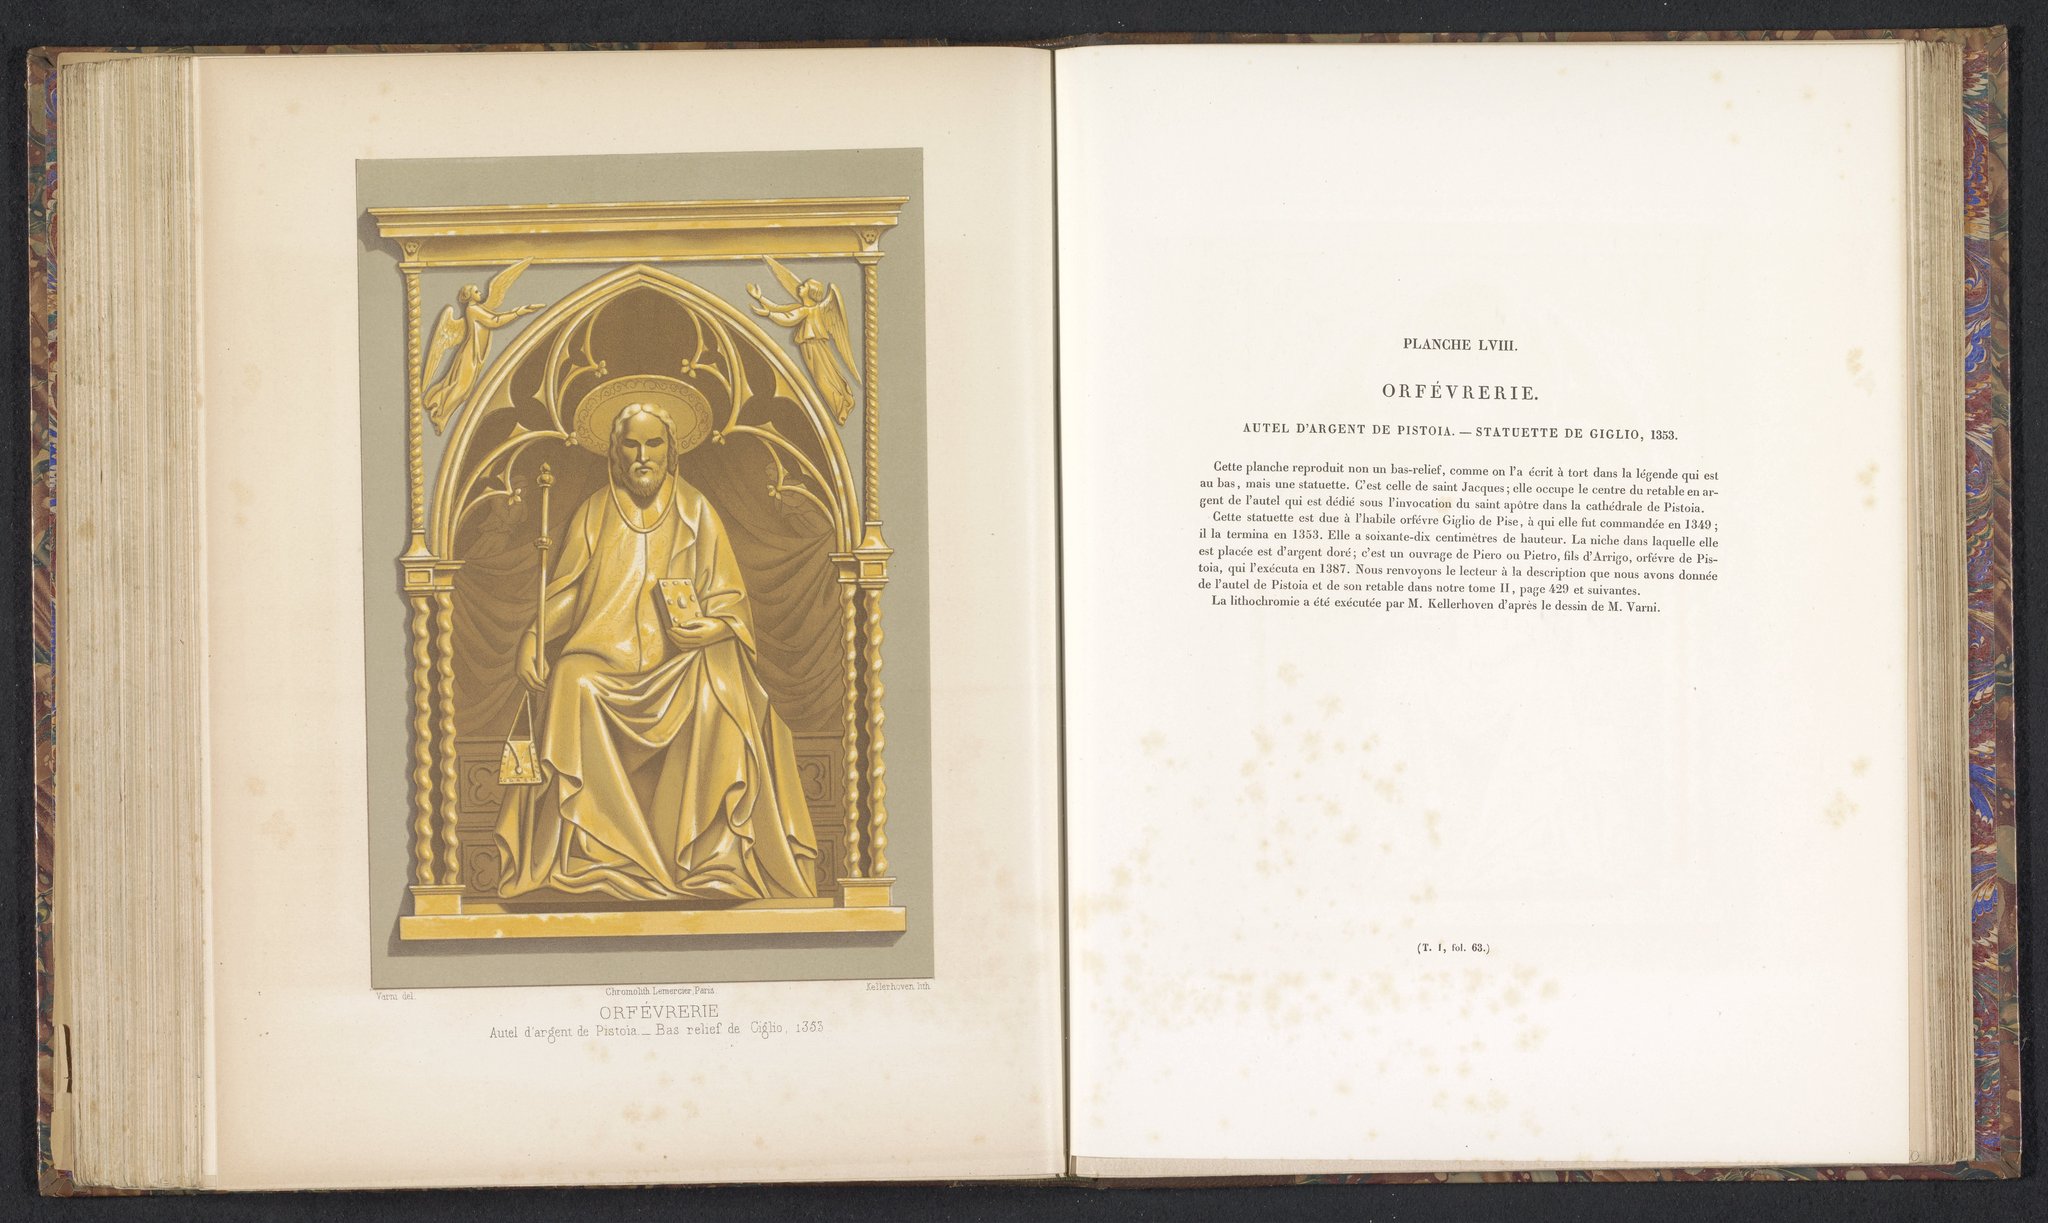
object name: print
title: Orfévrerie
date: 1859-1864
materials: paper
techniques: chromolithography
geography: paris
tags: altar, the apostle james the great; possible attributes: book, pilgrim's cloak, hat, shell, staff, and wallet, scroll, sword, sculpture (+ relief ~ sculpture)